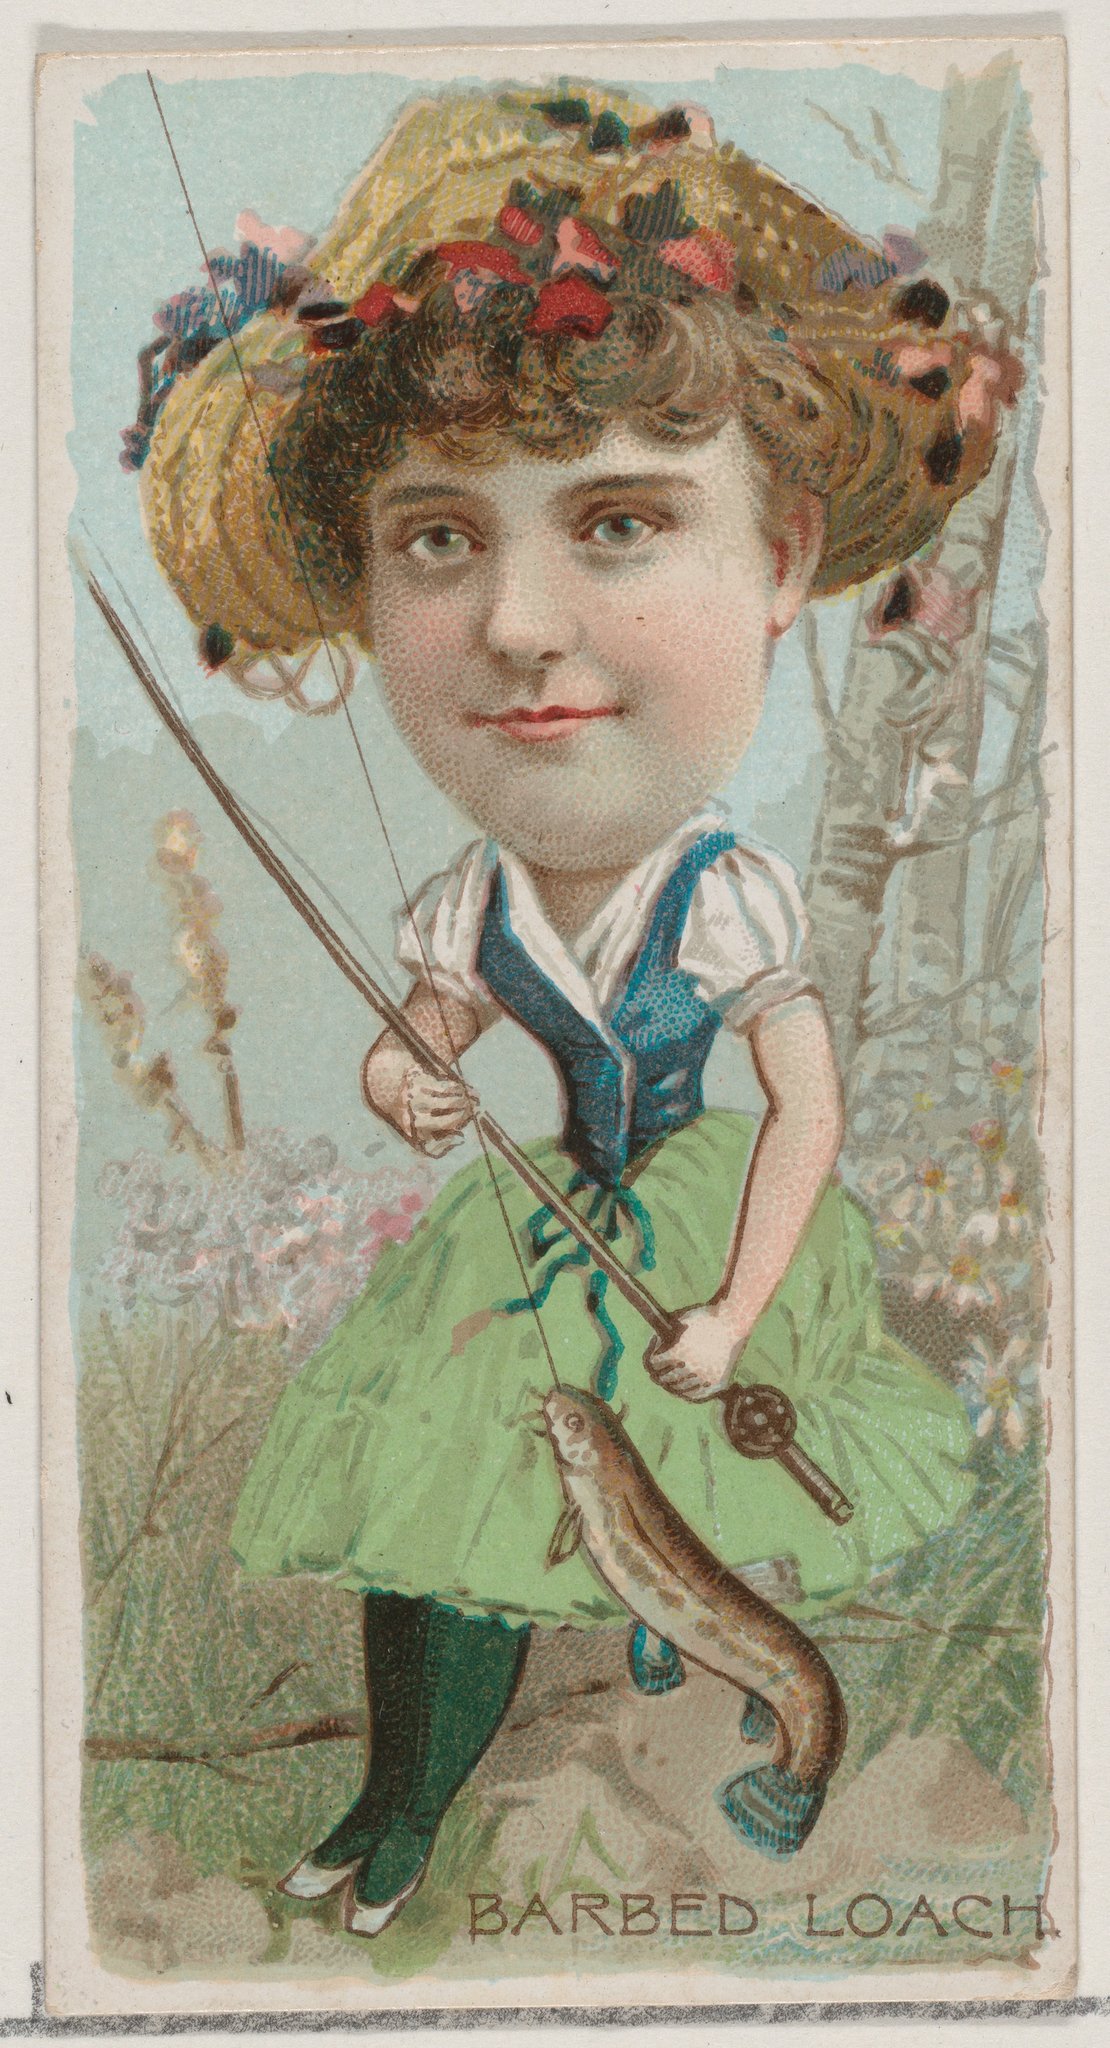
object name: print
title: Barbed Loach, from the series Fishers and Fish (N74) for Duke brand cigarettes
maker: knapp & company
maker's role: lithographer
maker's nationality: american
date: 1888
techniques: color lithograph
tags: women,fishing,fish